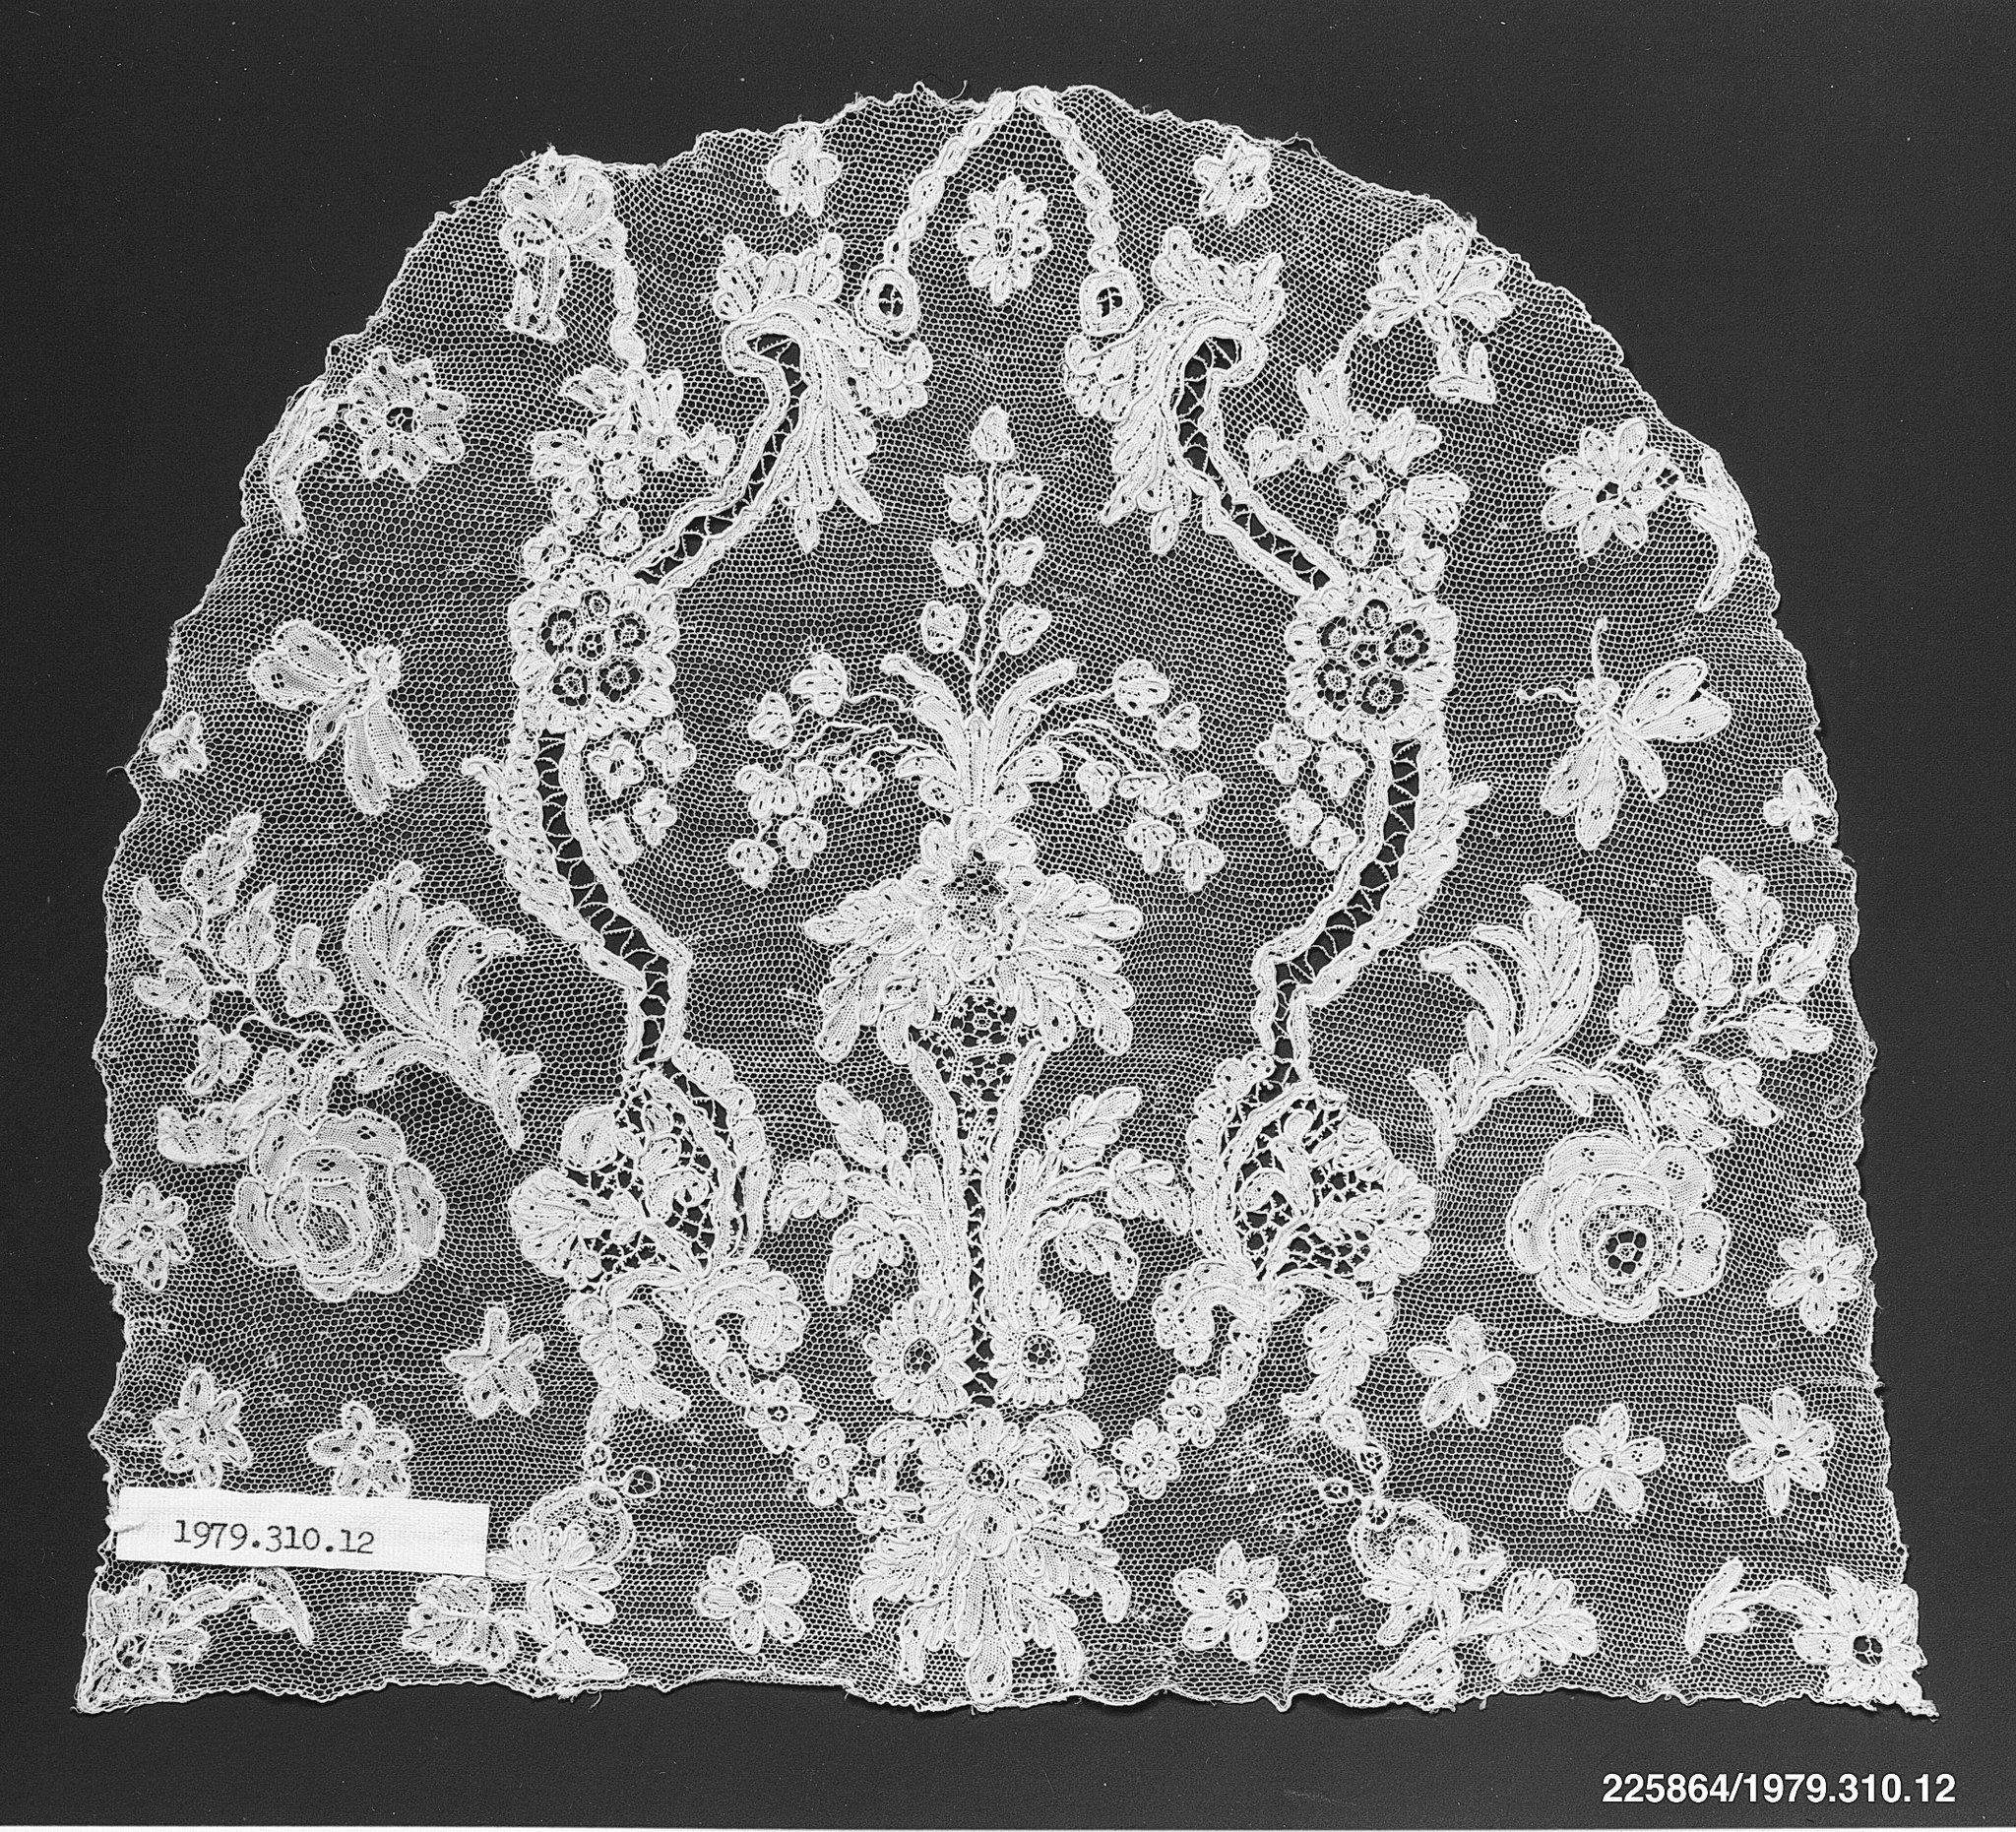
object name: cap crown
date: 1767-1833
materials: linen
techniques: lace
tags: butterflies,flowers